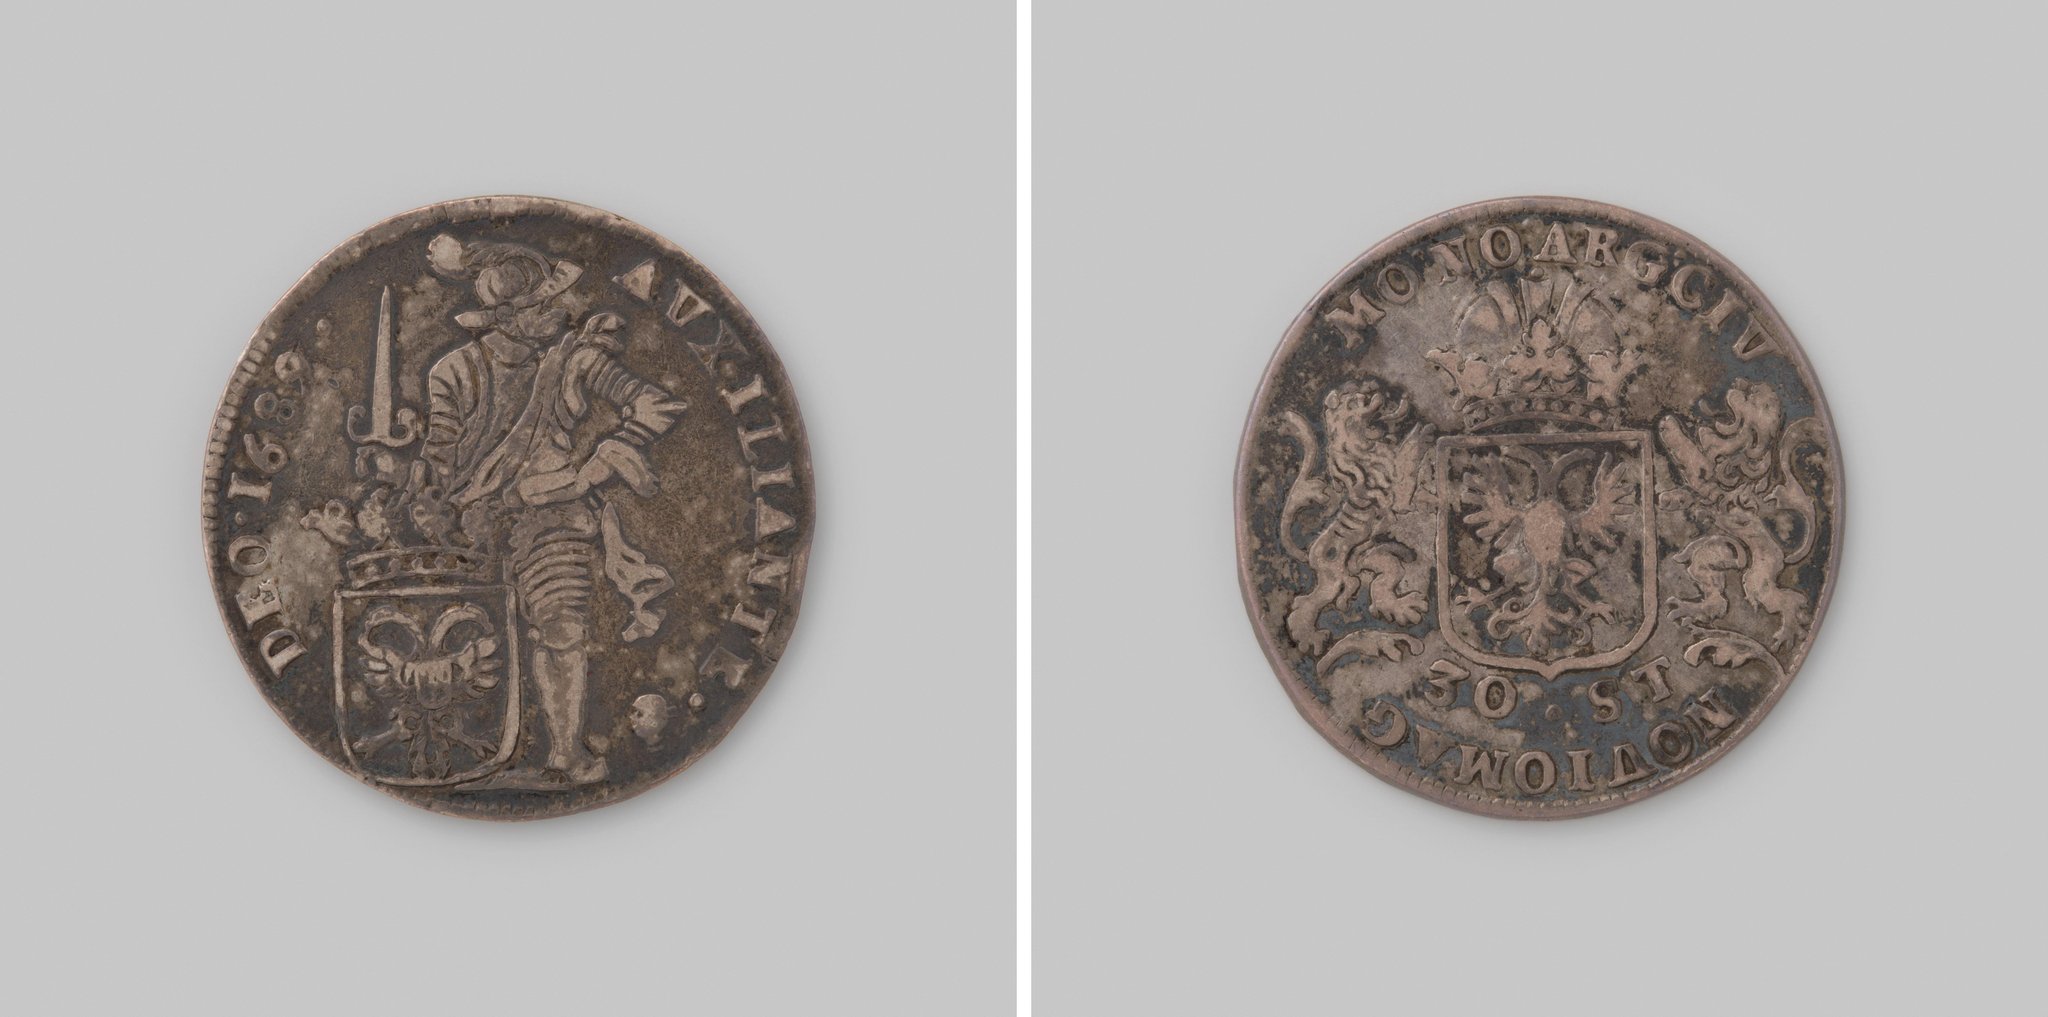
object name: coin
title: Nijmeegse daalder, 1689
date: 1689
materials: silver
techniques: striking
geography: nijmegen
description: Zilveren munt. Voorzijde: staande geharnaste ridder met geheven zwaard in rechterhand en gekroond wapenschild van Nijmegen voor zich. Keerzijde: gekroond wapenschild van Nijmegen, gehouden door twee leeuwen. Onder wapenschild waarde-aanduiding 30 ST.